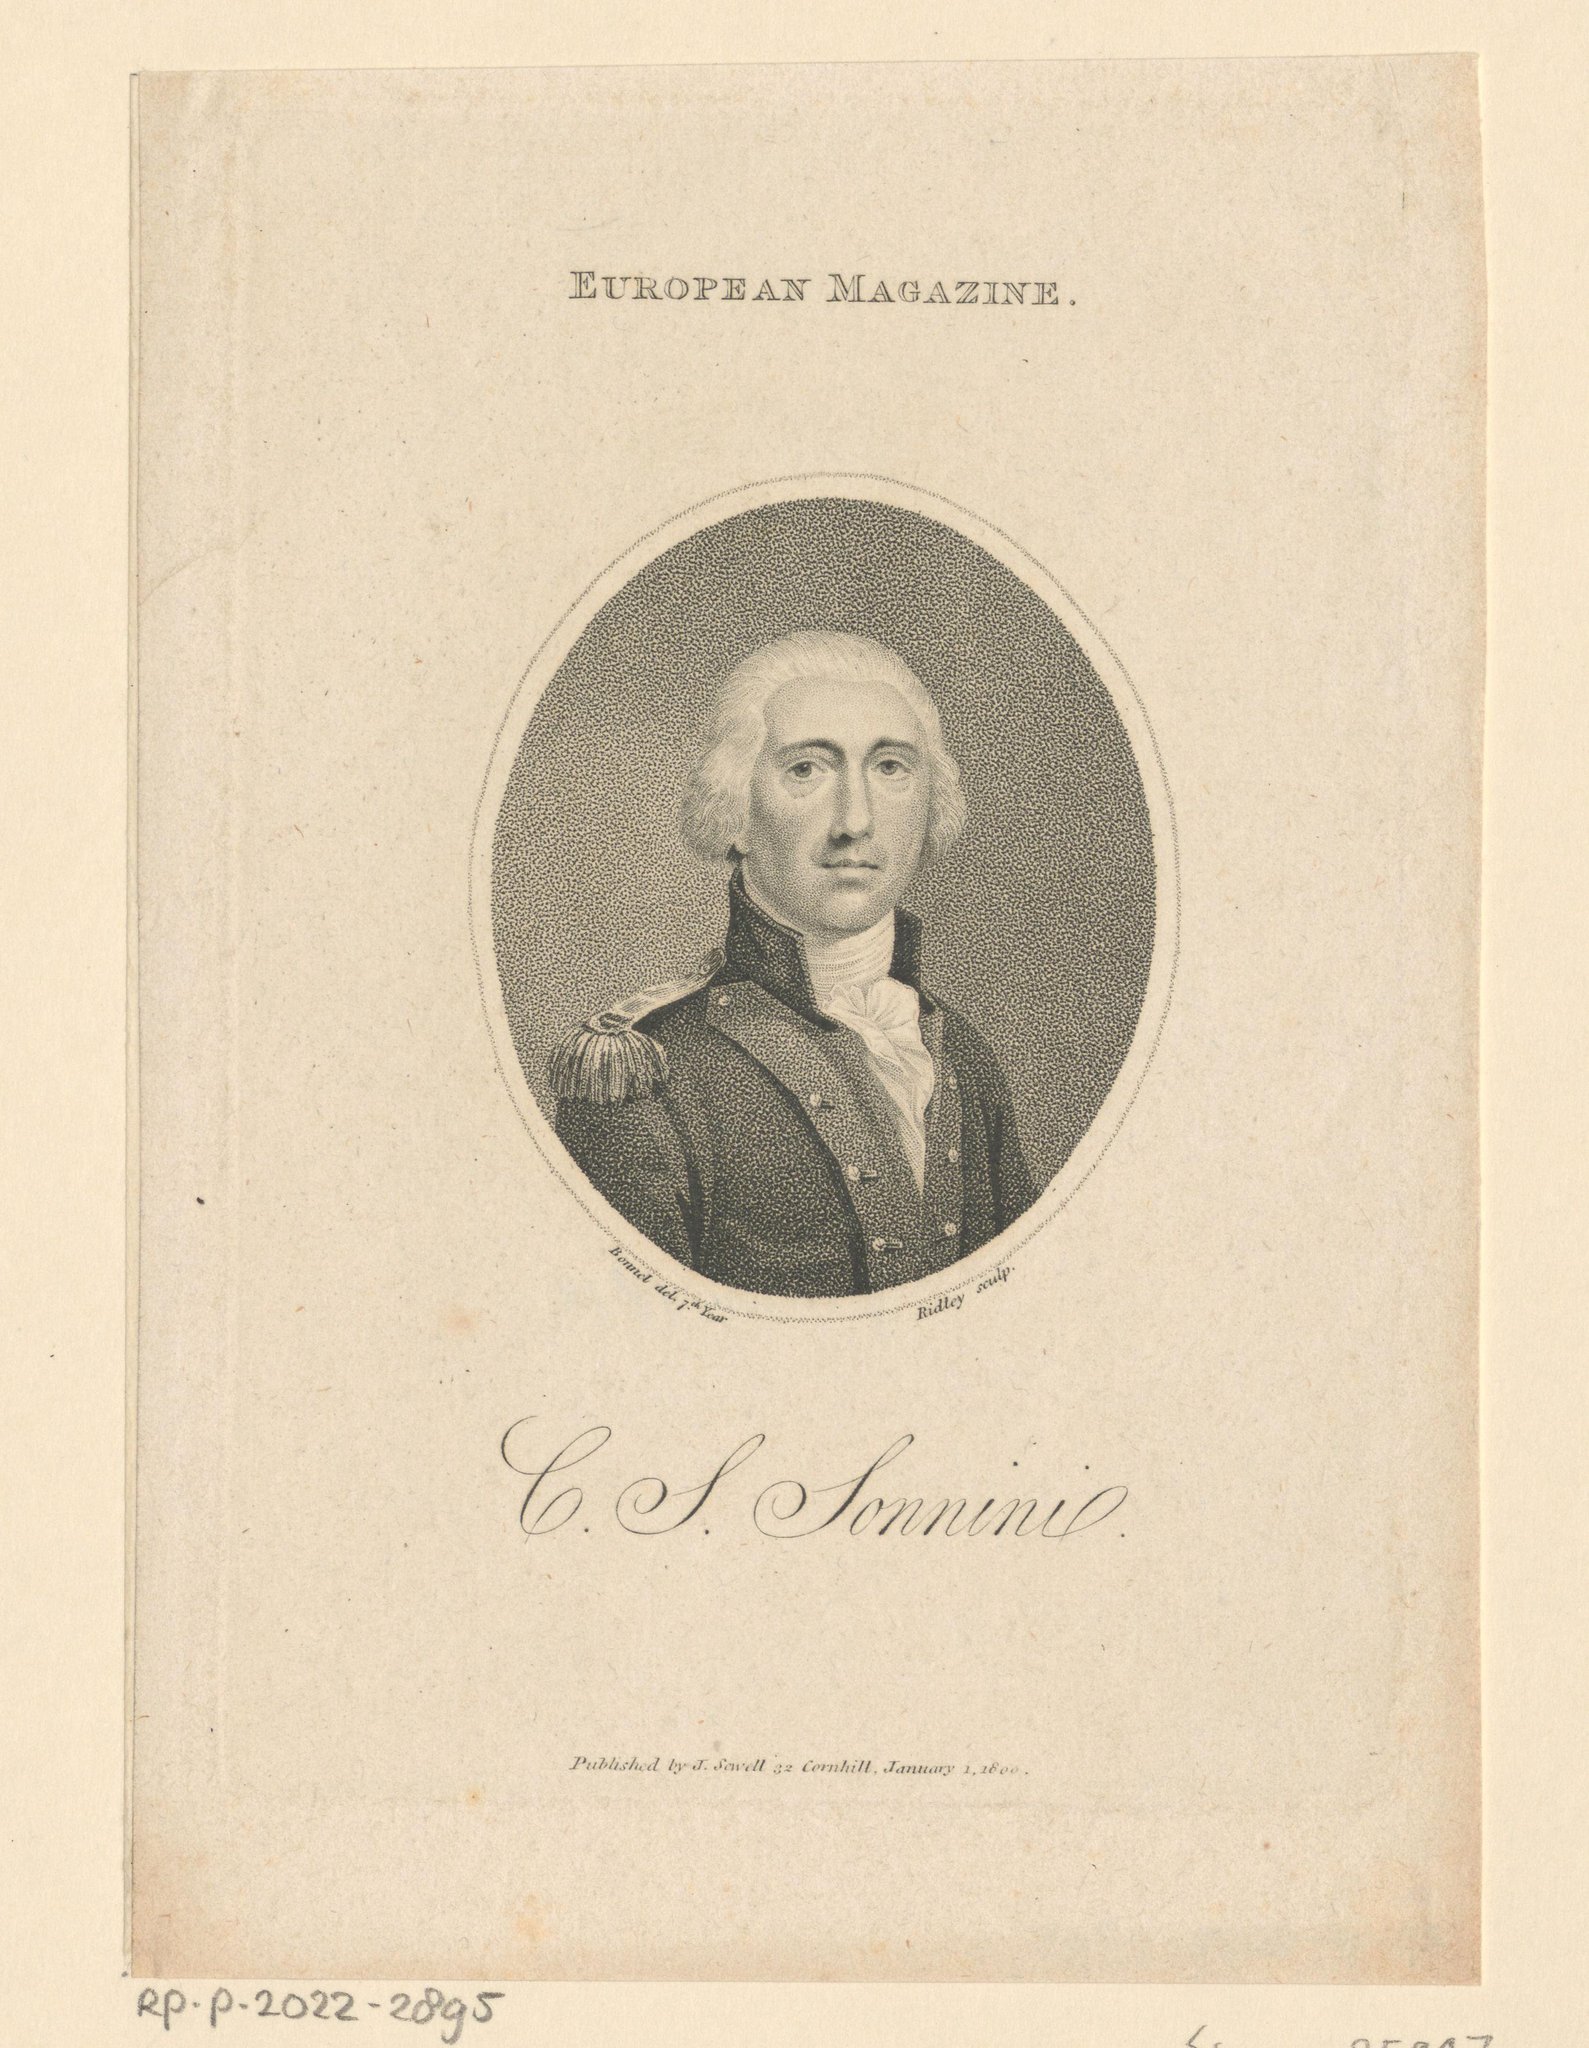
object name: print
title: Portret van Charles-Nicolas-Sigisbert Sonnini de Manoncourt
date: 1800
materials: paper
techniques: etching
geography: london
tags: paris, botany (+ portrait of scholar, scientist), historical persons, explorer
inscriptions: inscription: ‘+ / 9 mai 1812’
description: Prent waarschijnlijk uit: The European Magazine and London Review, by the Philological Society of London 37 (1800), 1 januari 1800.